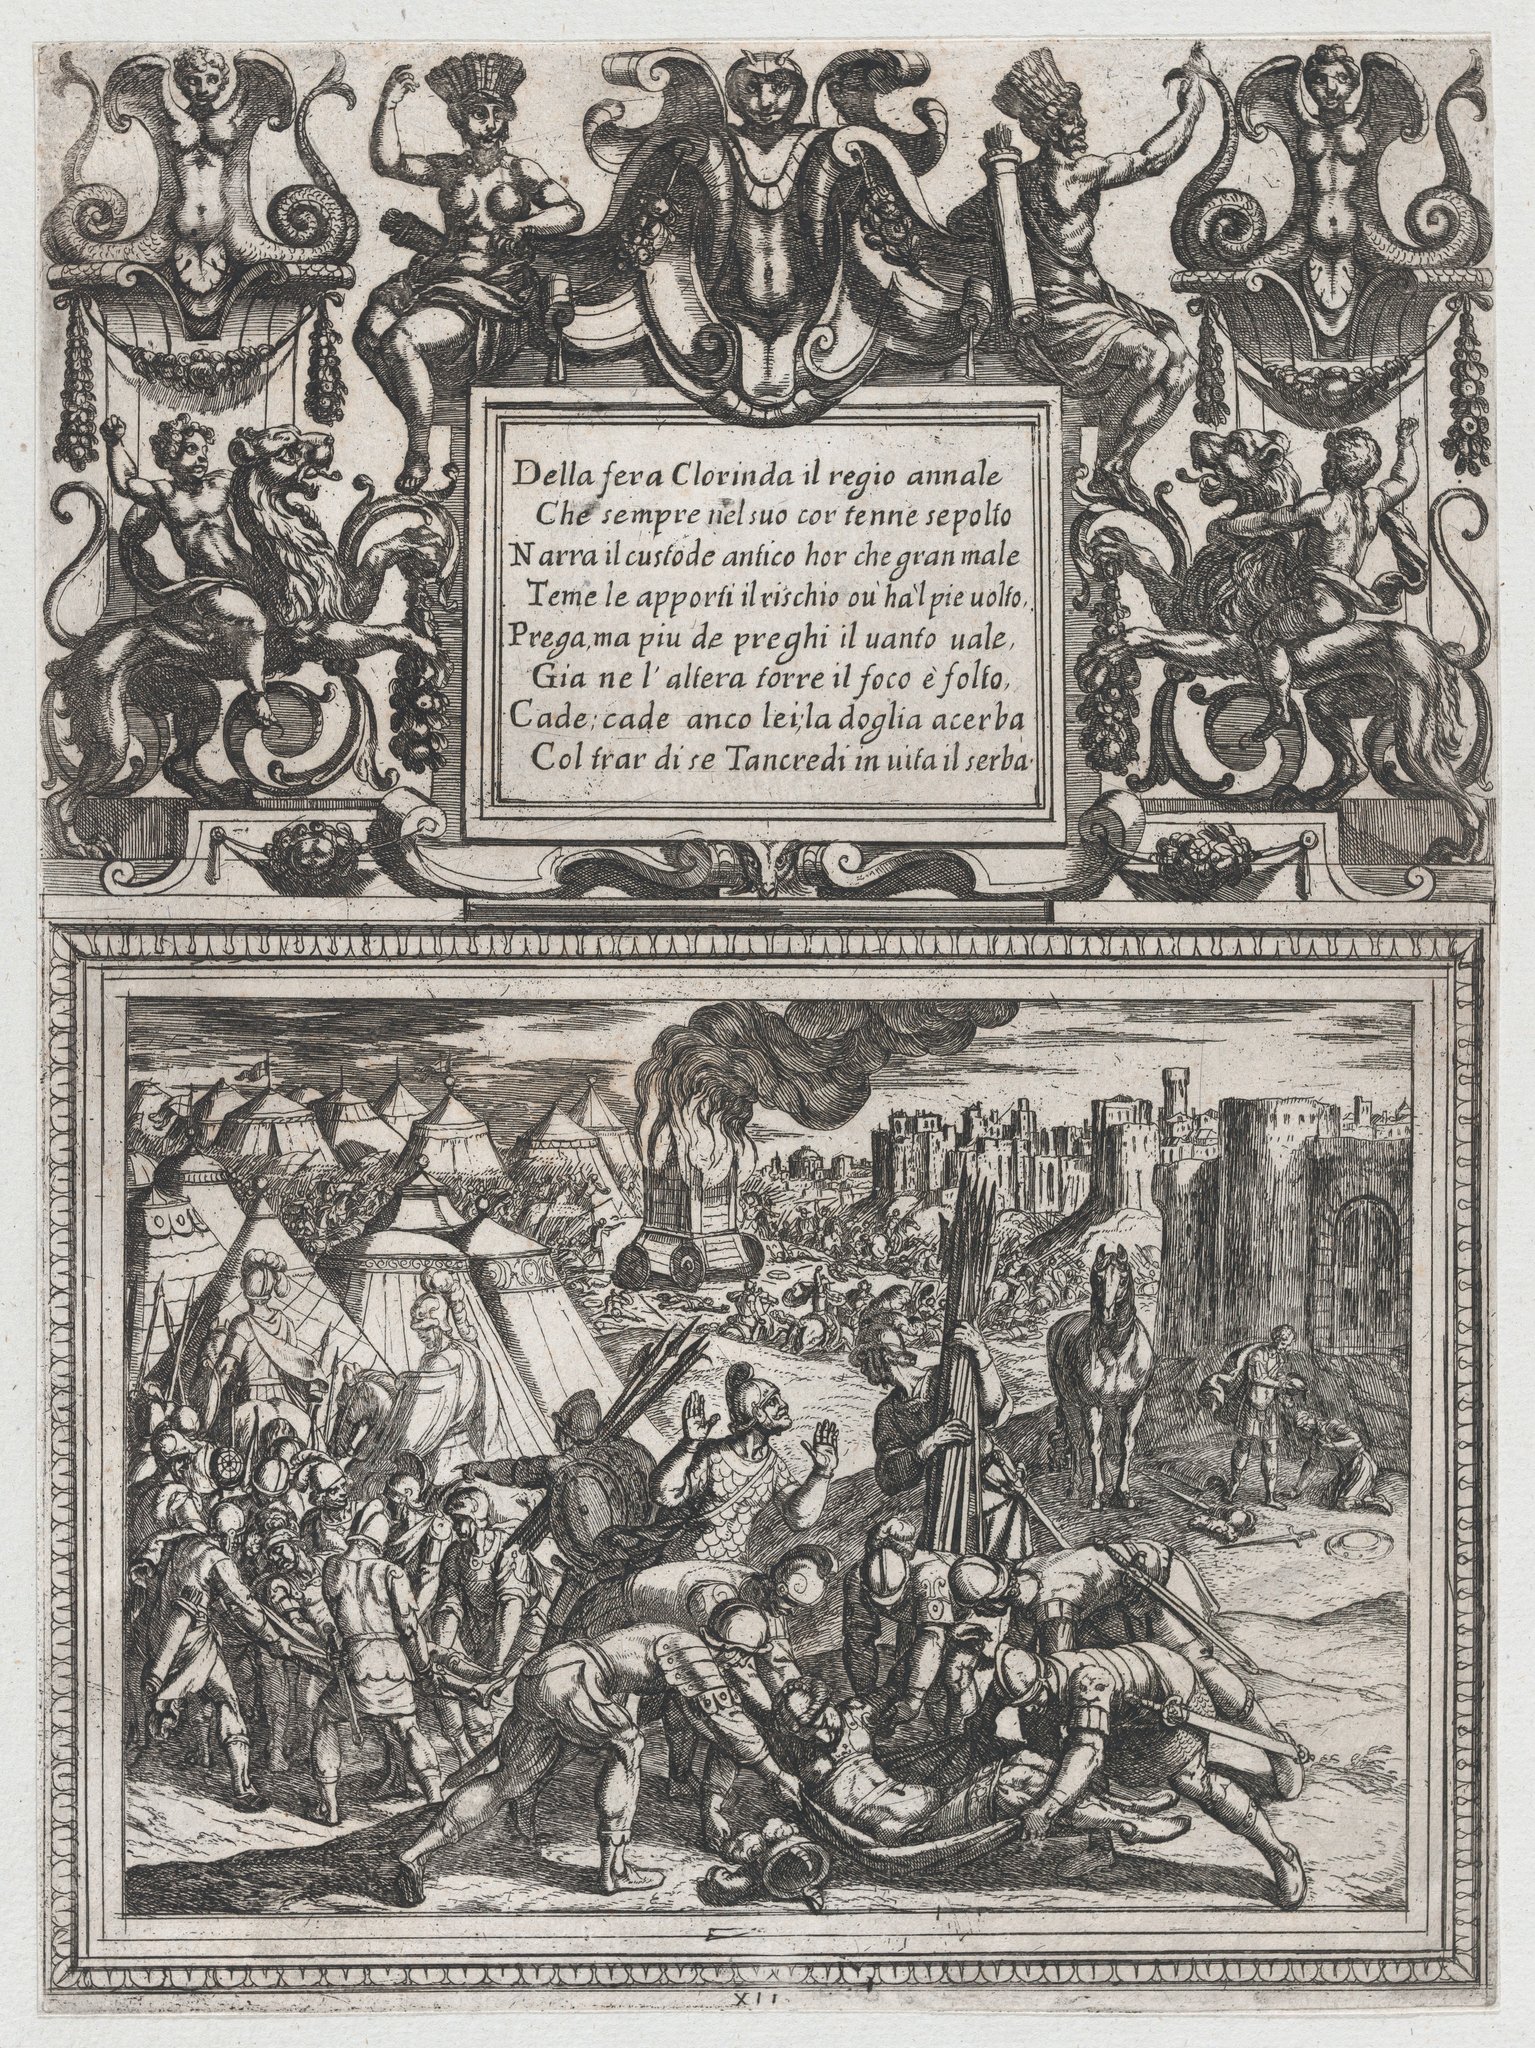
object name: print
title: Plate 12: Illustration to Canto XII, from Torquato Tasso's "Gerusalemme liberata III"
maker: antonio tempesta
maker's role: artist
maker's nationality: italian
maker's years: 1555-1630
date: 1590-1630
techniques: etching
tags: battles,soldiers,lions